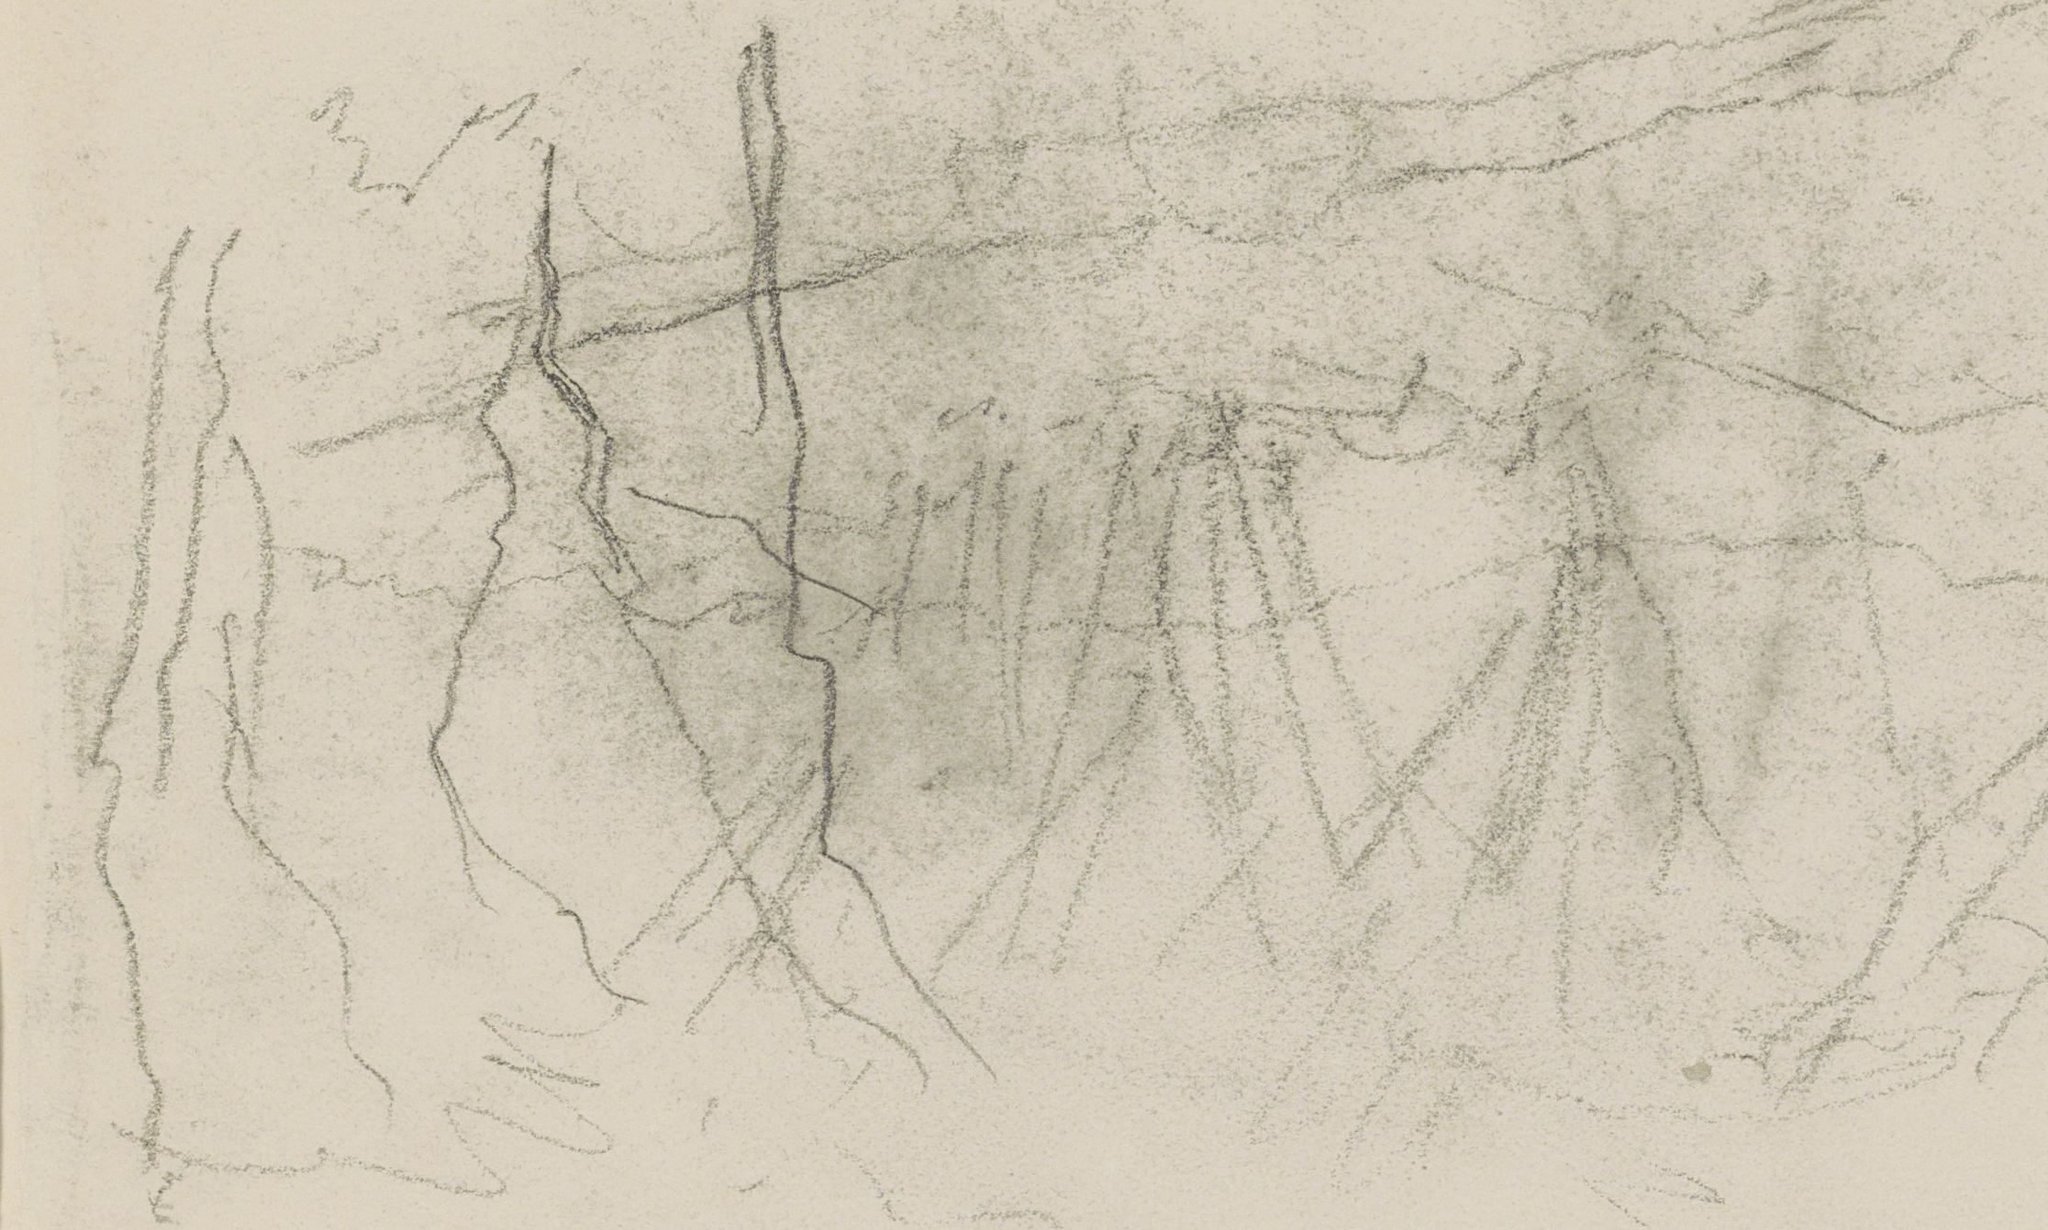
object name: sketchbook leaf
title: Landschap met bomen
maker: anton mauve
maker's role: draughtsman, painter, print maker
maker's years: 1838-1888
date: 1848-1888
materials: chalk, paper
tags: landscapes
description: Blad 33 recto uit een schetsboek met 33 bladen.